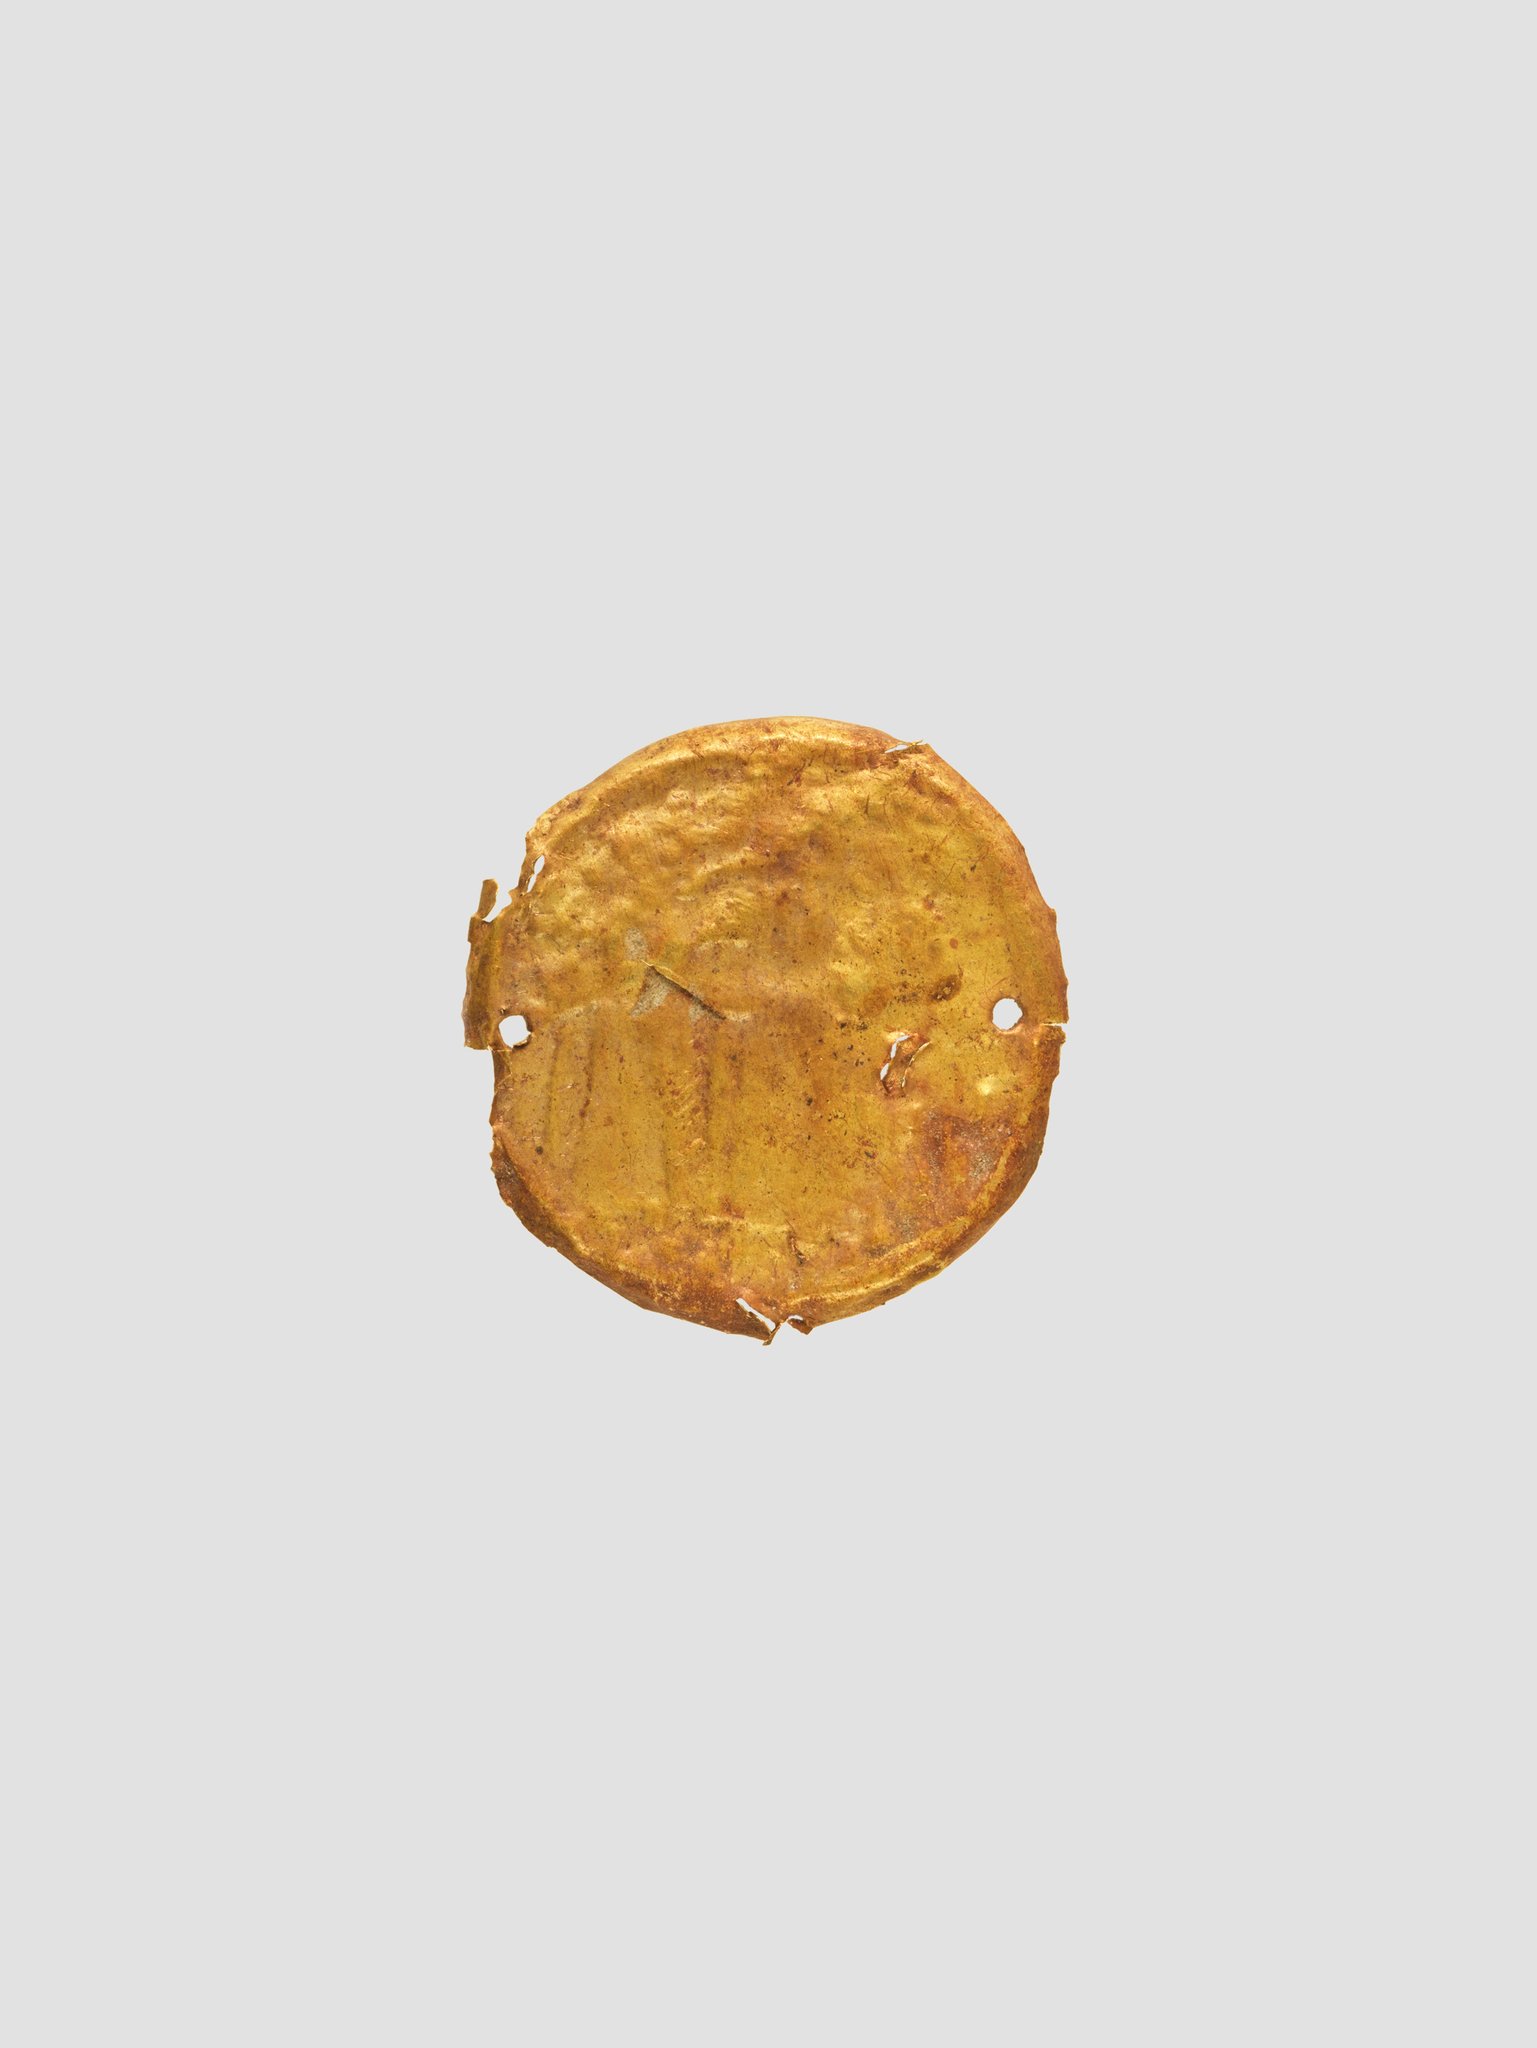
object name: bracteate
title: Gold foil bracteate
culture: alanic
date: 601-900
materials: gold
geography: caucasus